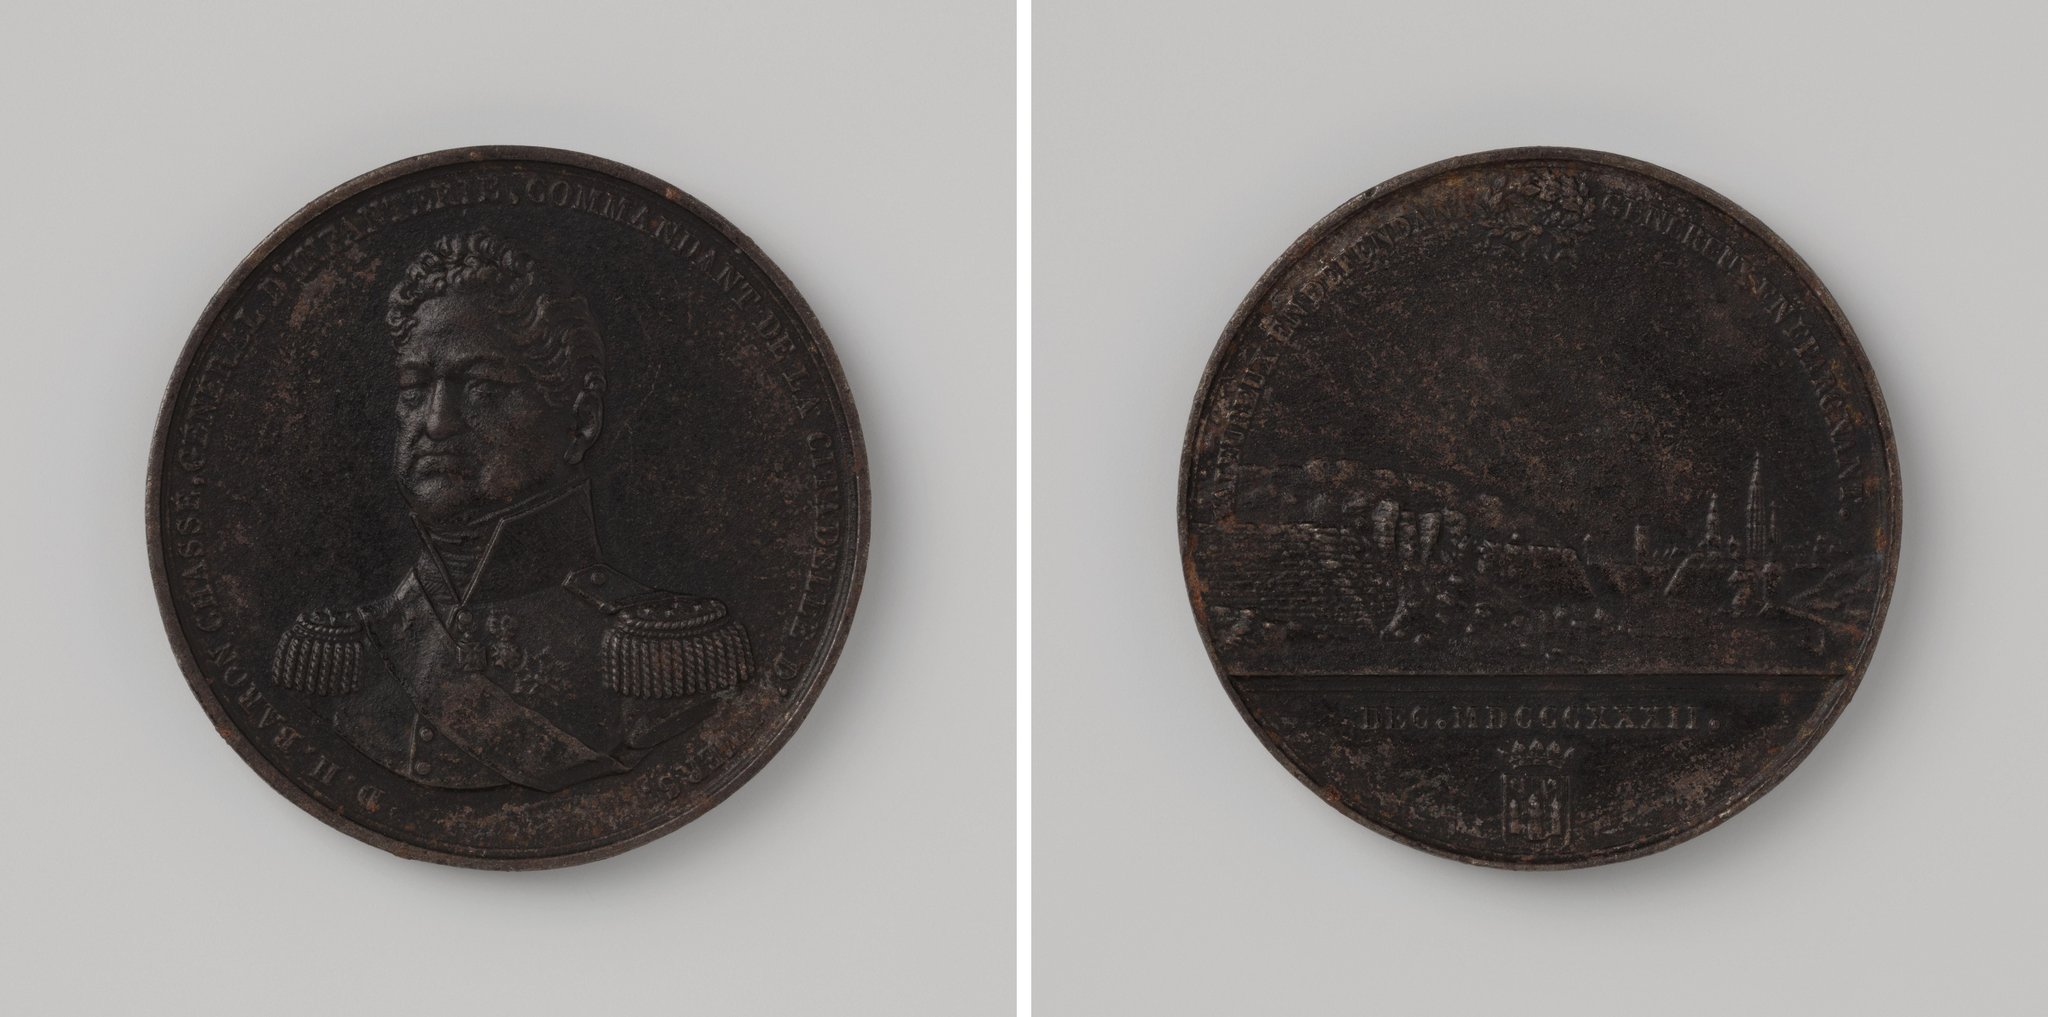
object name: history medal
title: Generaal Chassé spaart de stad Antwerpen 1832, afgieting in ijzer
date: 1832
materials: iron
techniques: casting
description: Gegoten ijzeren penning, op de voorzijde het borstbeeld van Chassé half naar links met omschrift, op de keerzijde de beschadigde Citadel van Antwerpen met een omschrift waarbinnen een kleine lauwerkrans en in afsnede een tekst boven een gekroond Antwerpens wapenschildje.